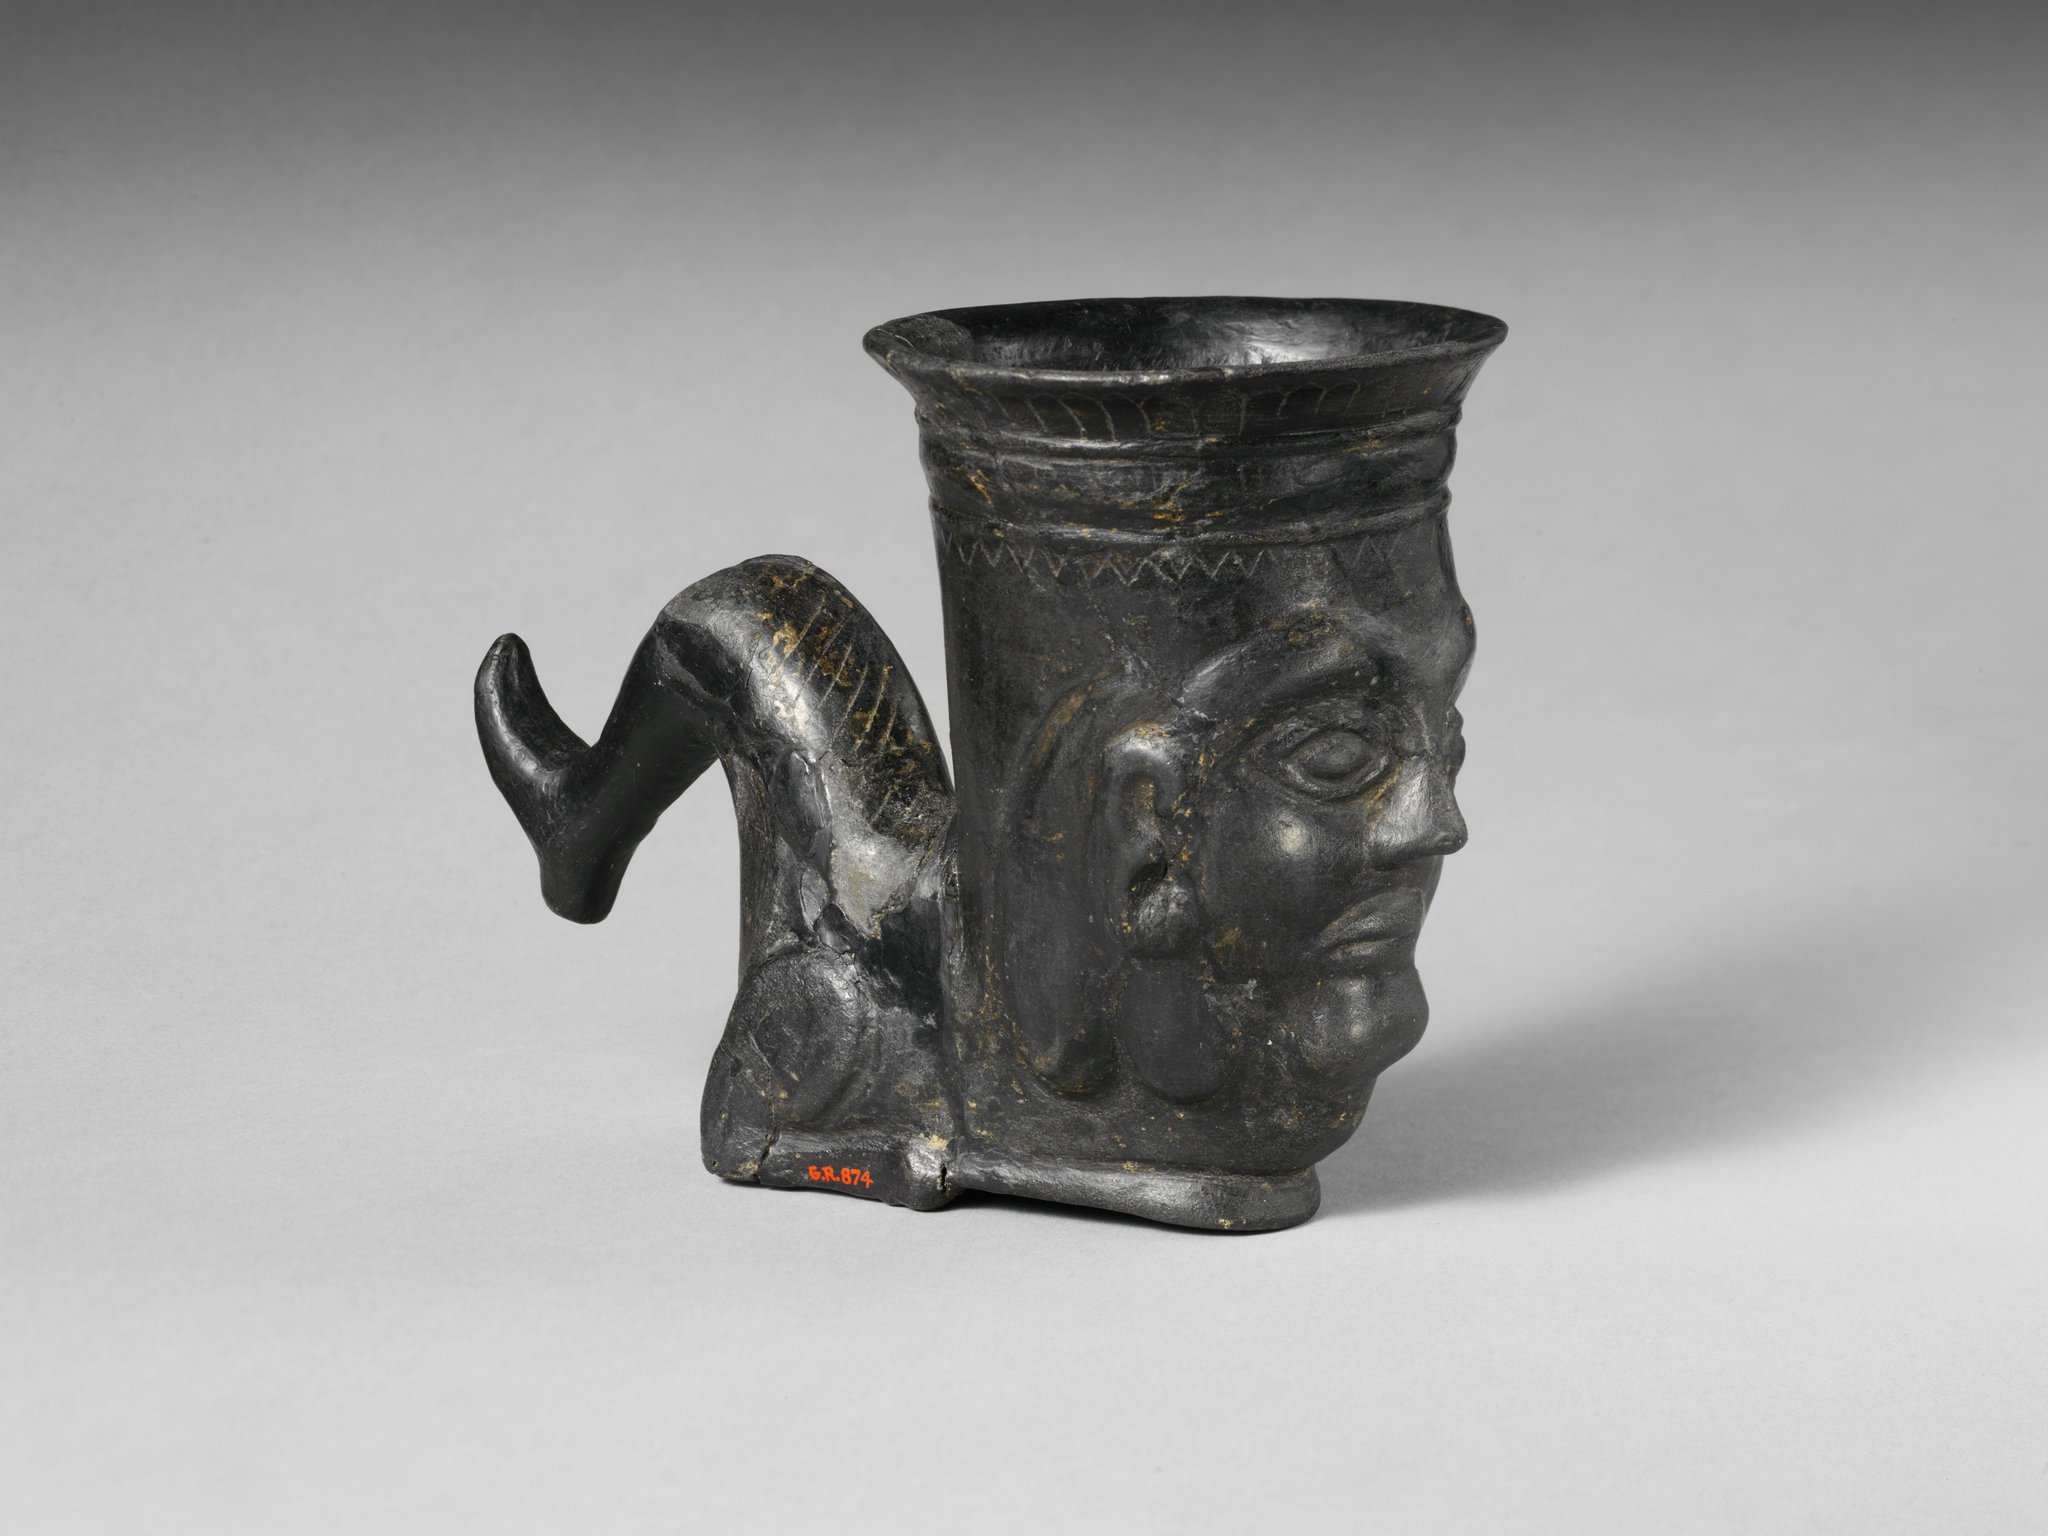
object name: vase in the form of a head and bent leg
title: Terracotta vessel in the shape of a bent leg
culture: etruscan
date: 550-500 BCE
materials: terracotta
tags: heads,legs